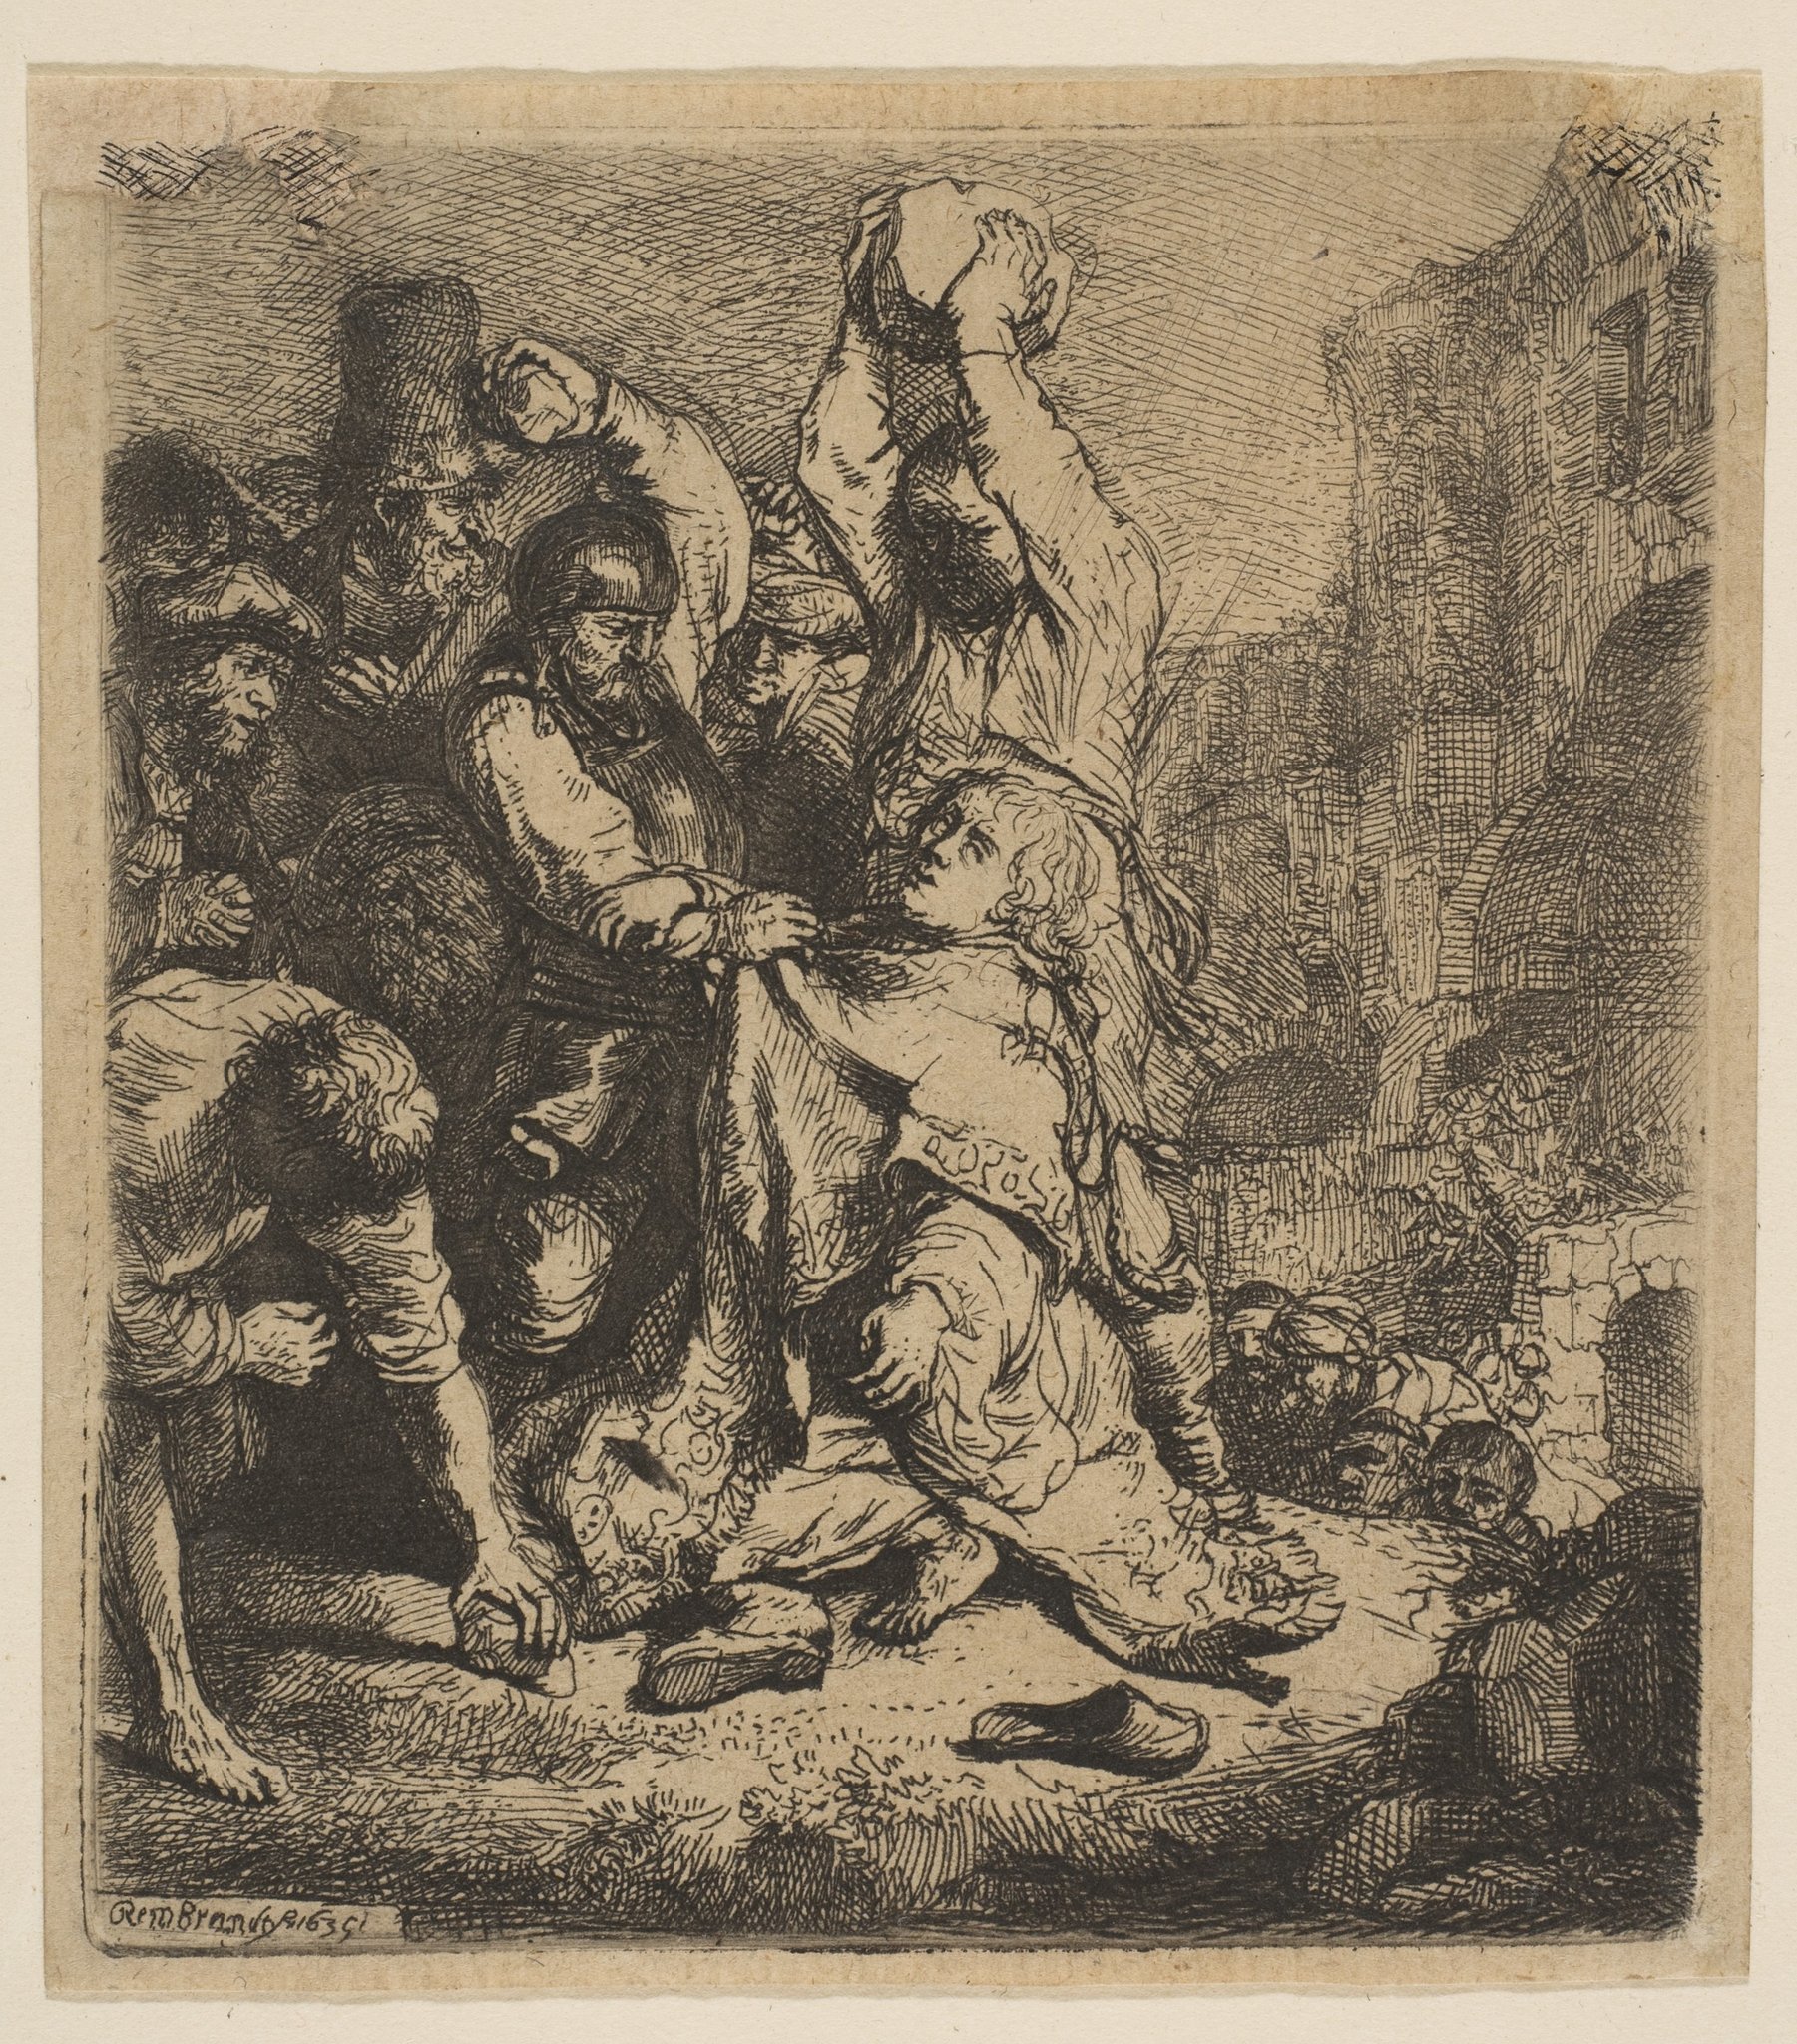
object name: print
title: The Stoning of St. Stephen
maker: rembrandt van rijn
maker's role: artist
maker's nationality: dutch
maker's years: 1606-1669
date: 1635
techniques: etching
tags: men,saints